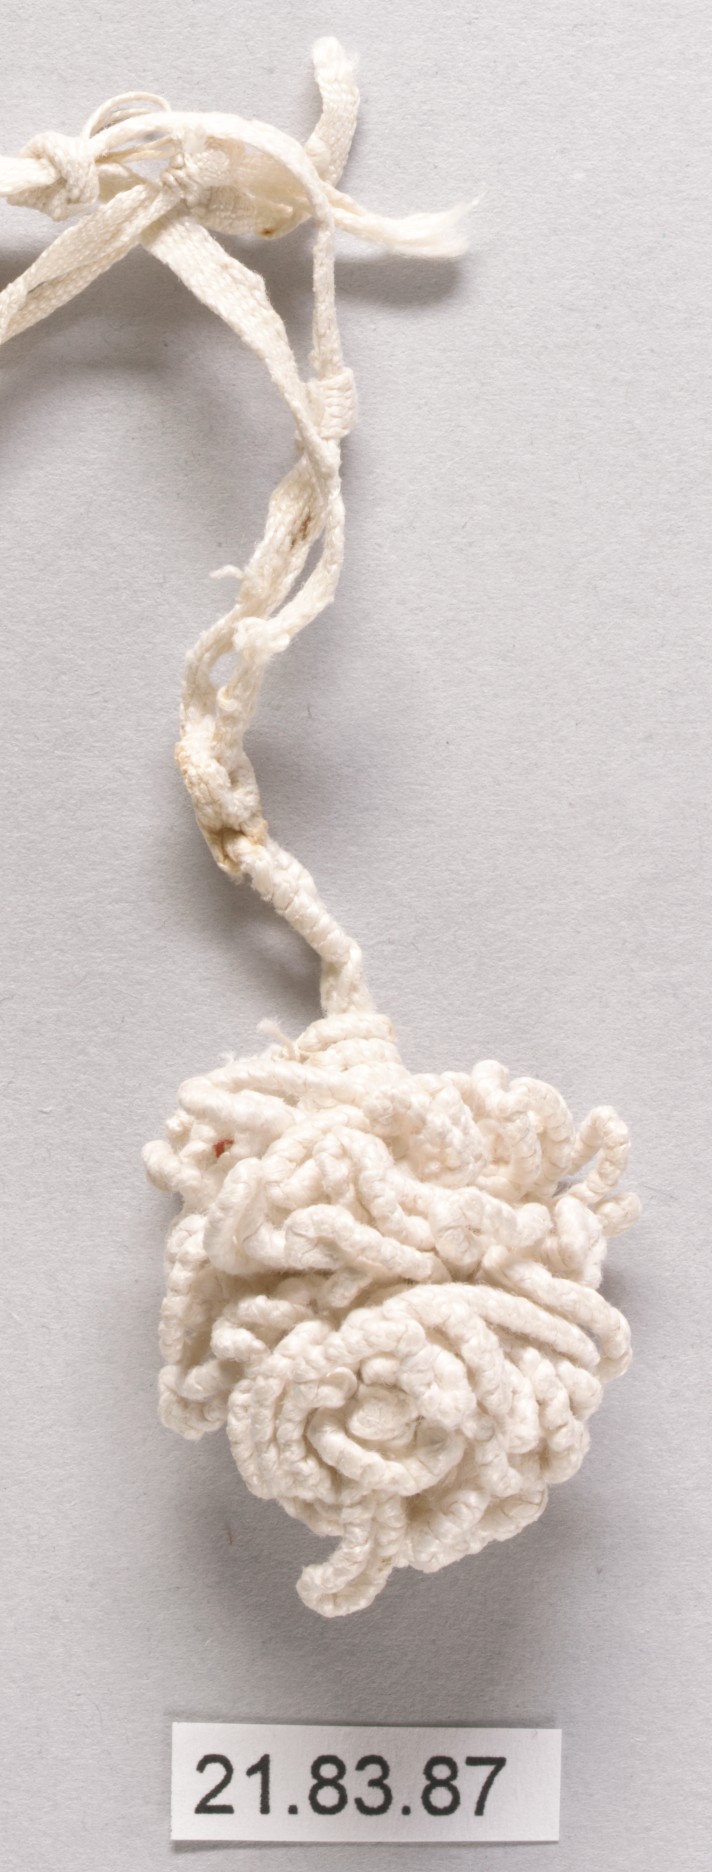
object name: tassel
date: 1601-1700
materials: linen